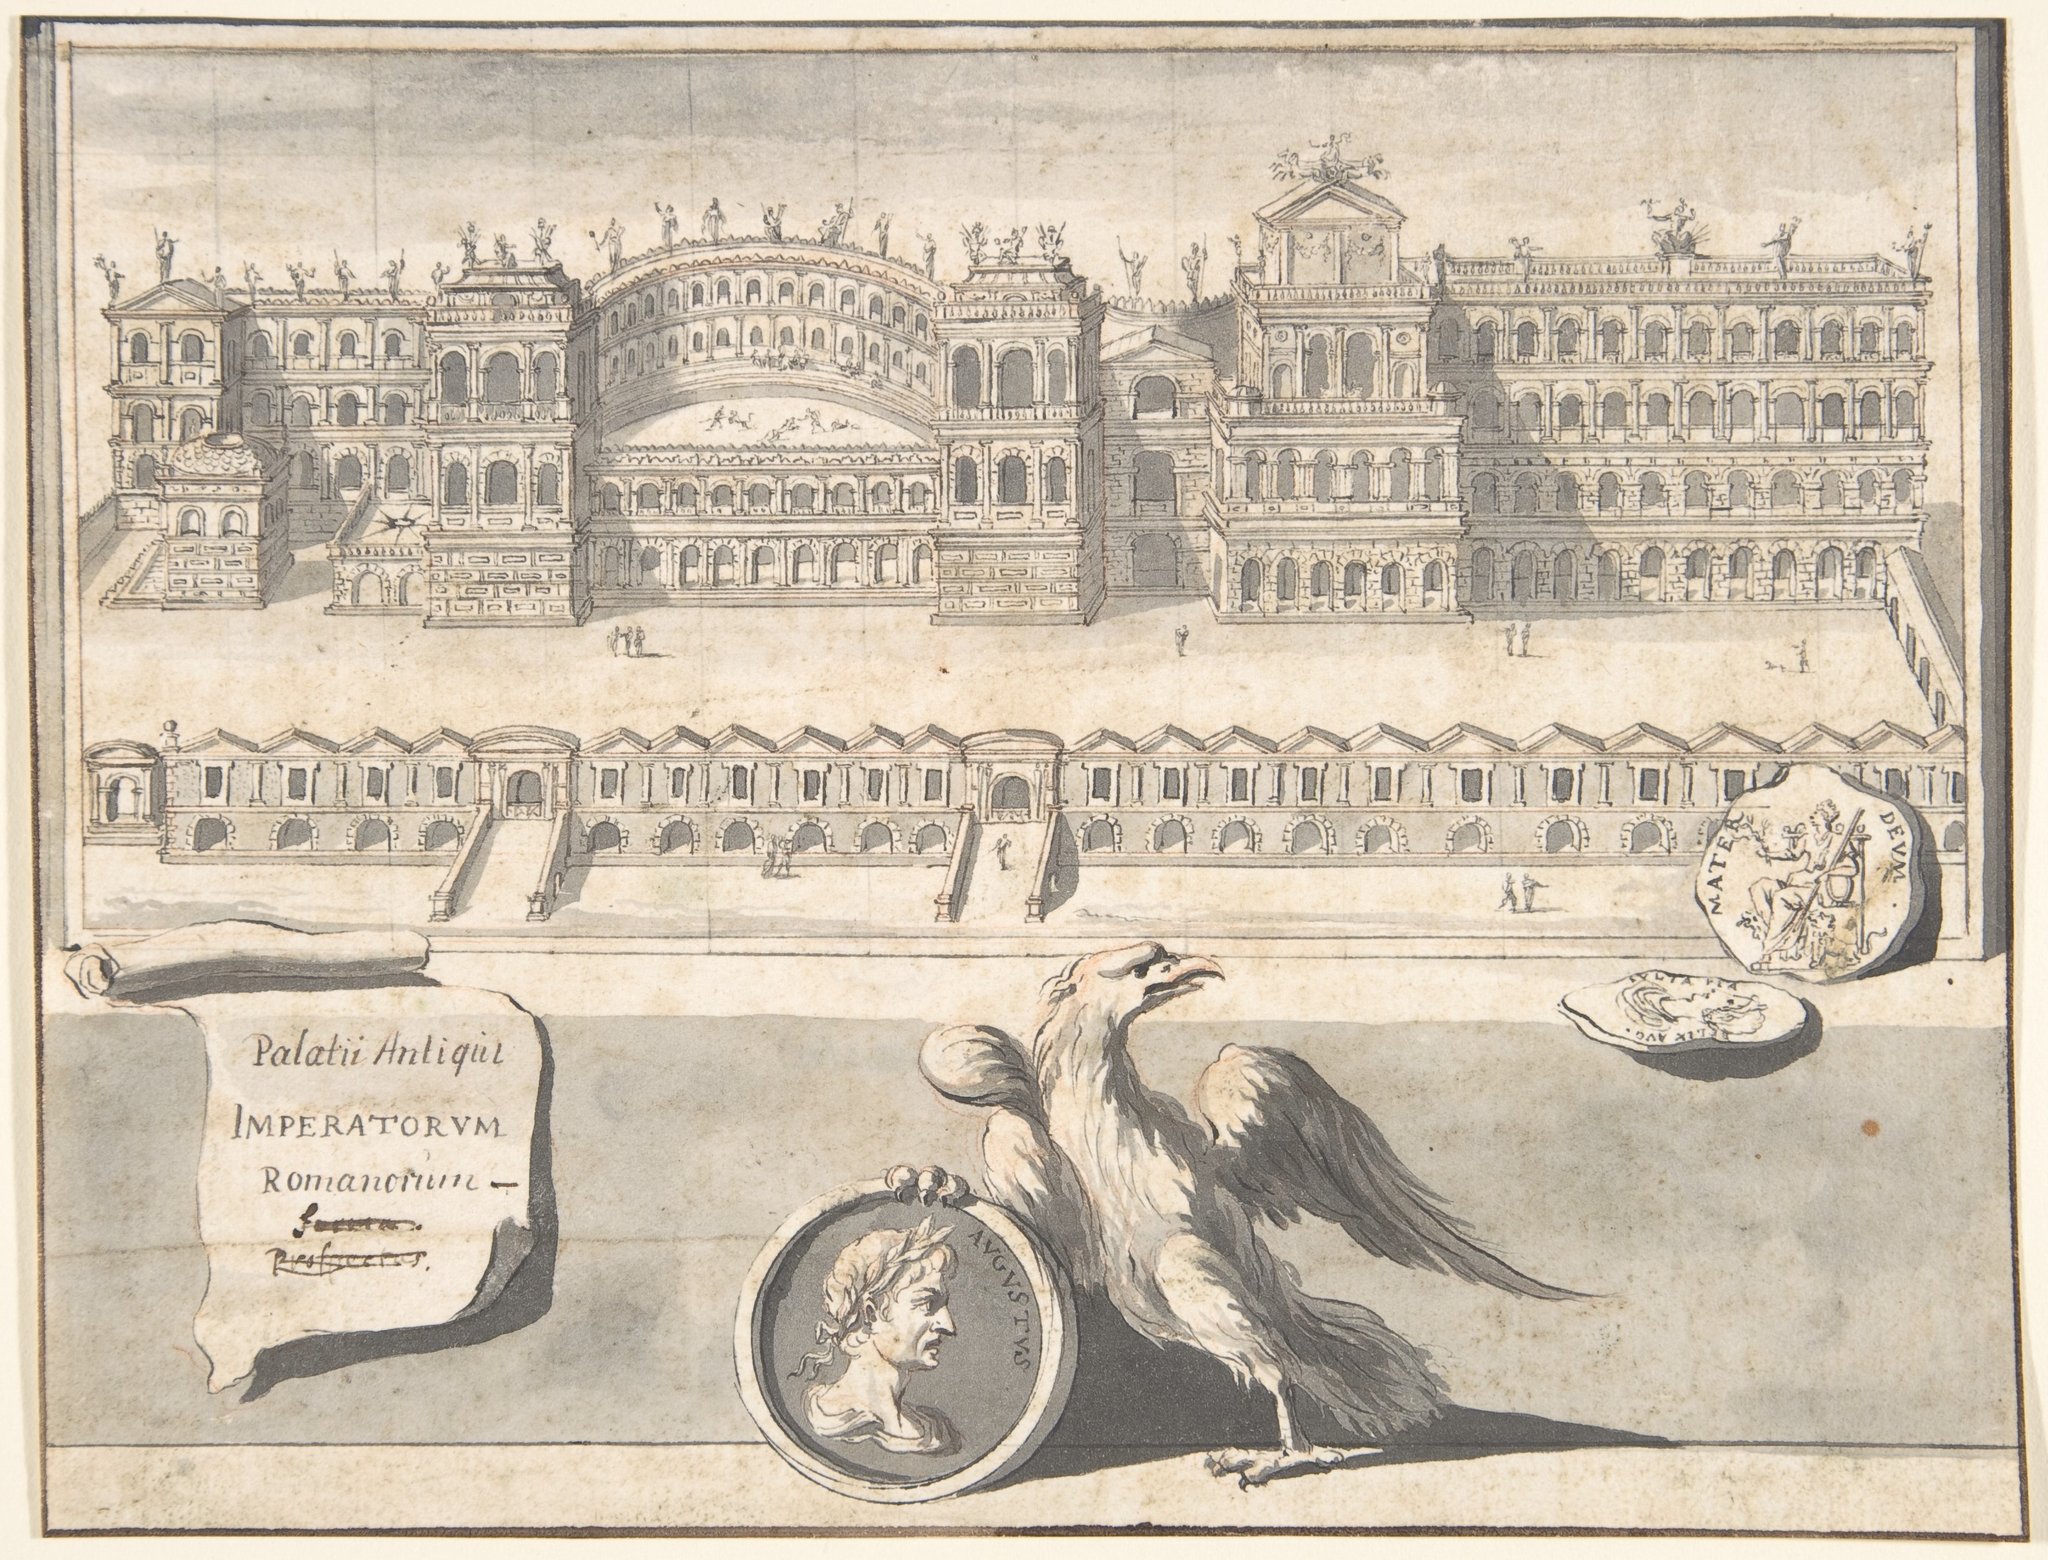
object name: drawing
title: A Reconstructed View of the Palace on the Palantine Hill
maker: jan goeree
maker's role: artist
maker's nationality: dutch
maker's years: 1670-1731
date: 1704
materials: chalk, ink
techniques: brush, pen, drawing, wash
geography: italy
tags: eagles,palaces,profiles